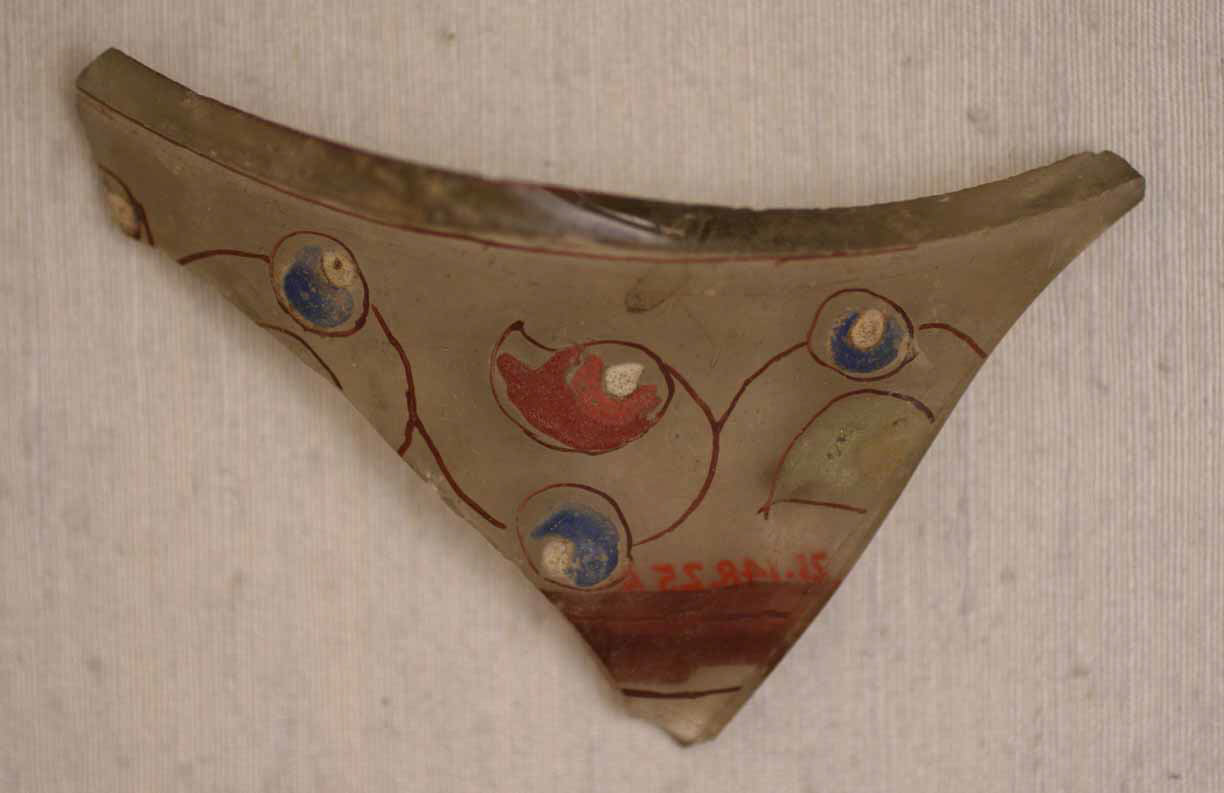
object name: fragment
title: Fragments of Lamp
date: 1301-1500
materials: glass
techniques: enamel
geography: egypt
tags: flowers